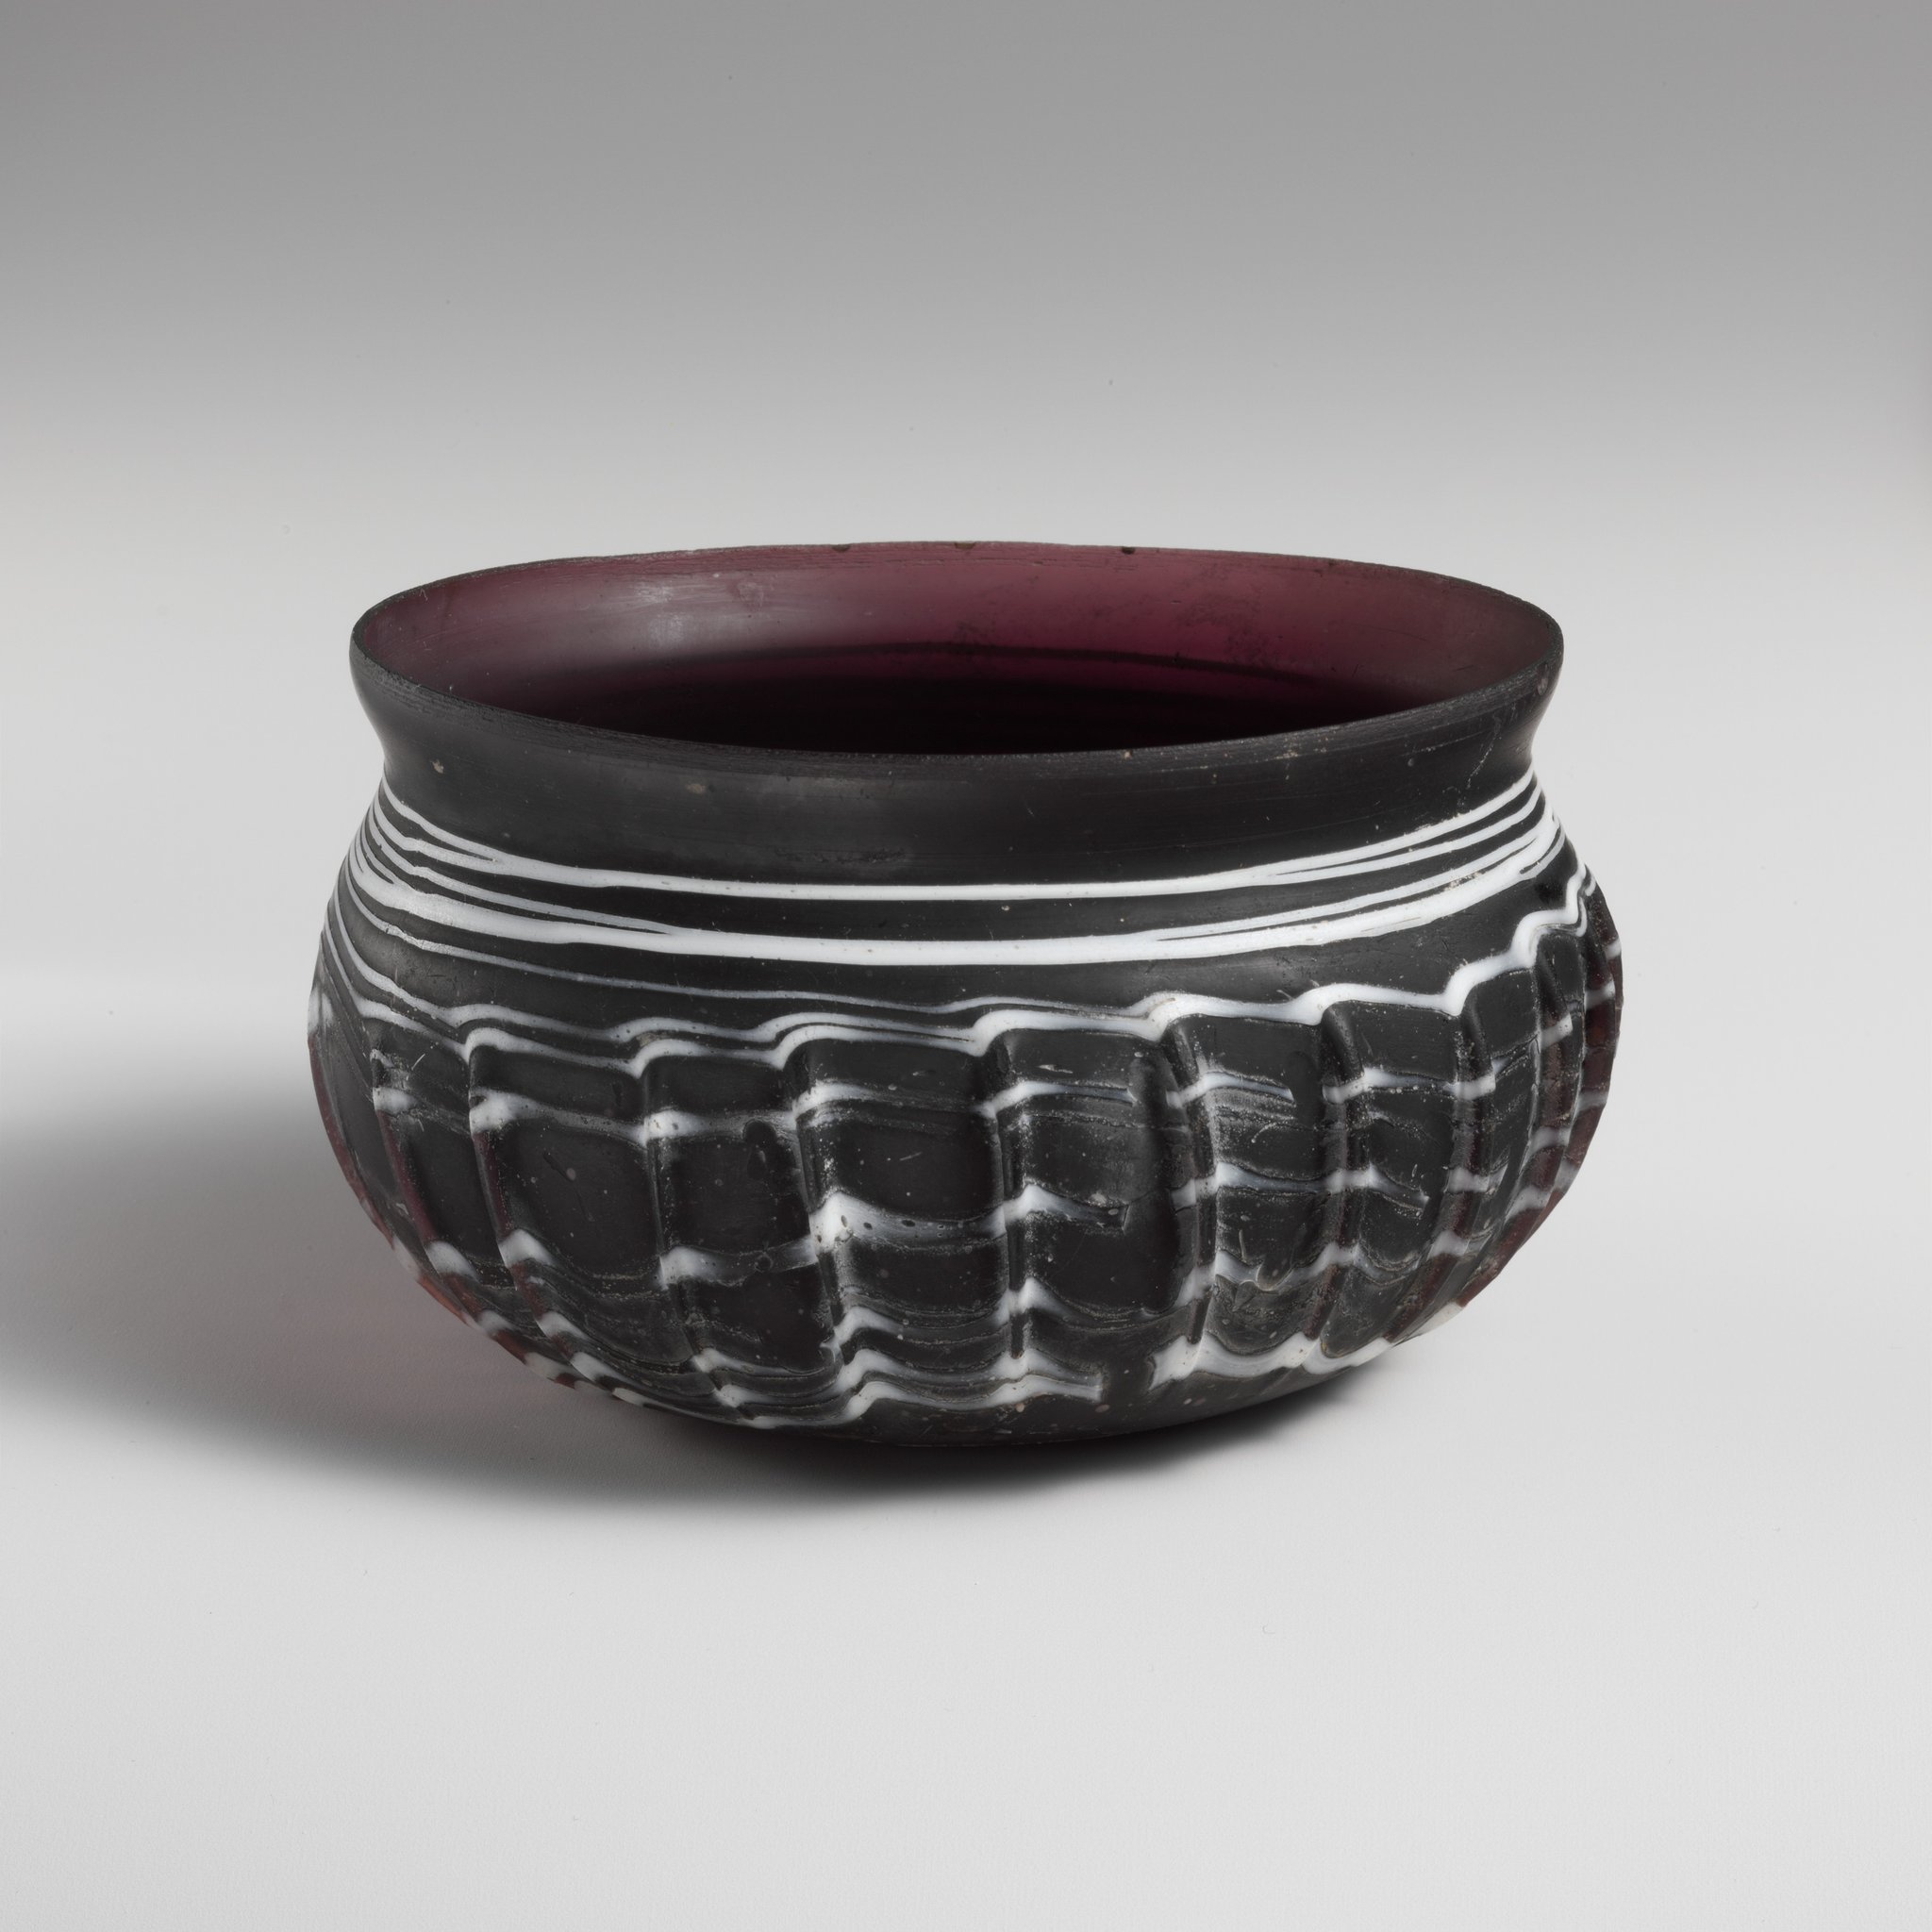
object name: bowl, rippenschale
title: Glass ribbed bowl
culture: roman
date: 34-66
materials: glass